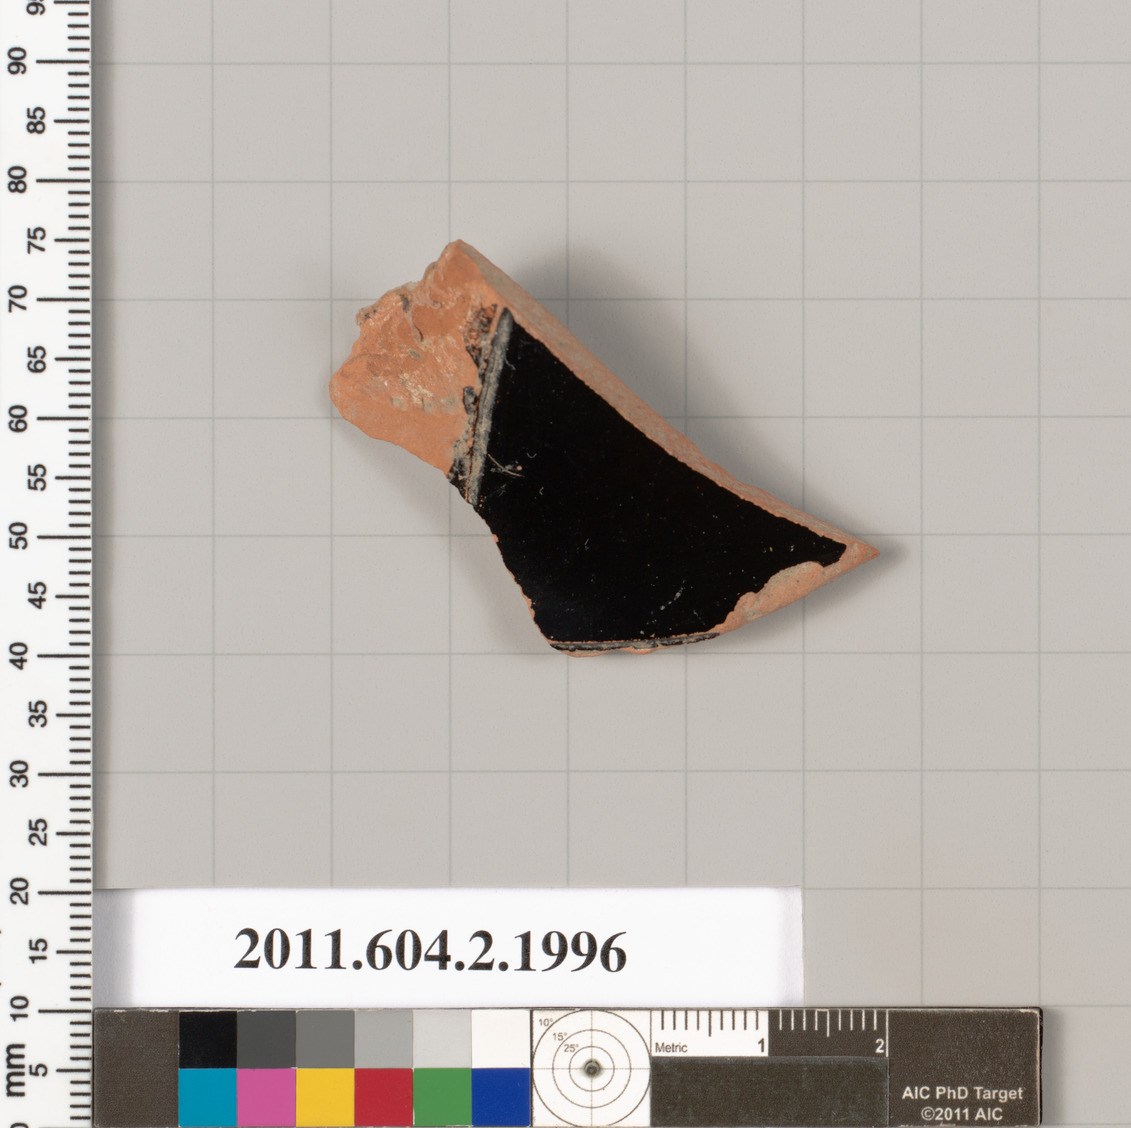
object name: pelike fragment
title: Terracotta fragment of a pelike (jar)?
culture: greek, attic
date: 475-451 BCE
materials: terracotta